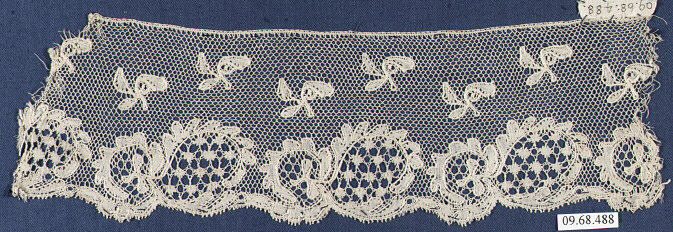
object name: fragment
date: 1801-1900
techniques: lace